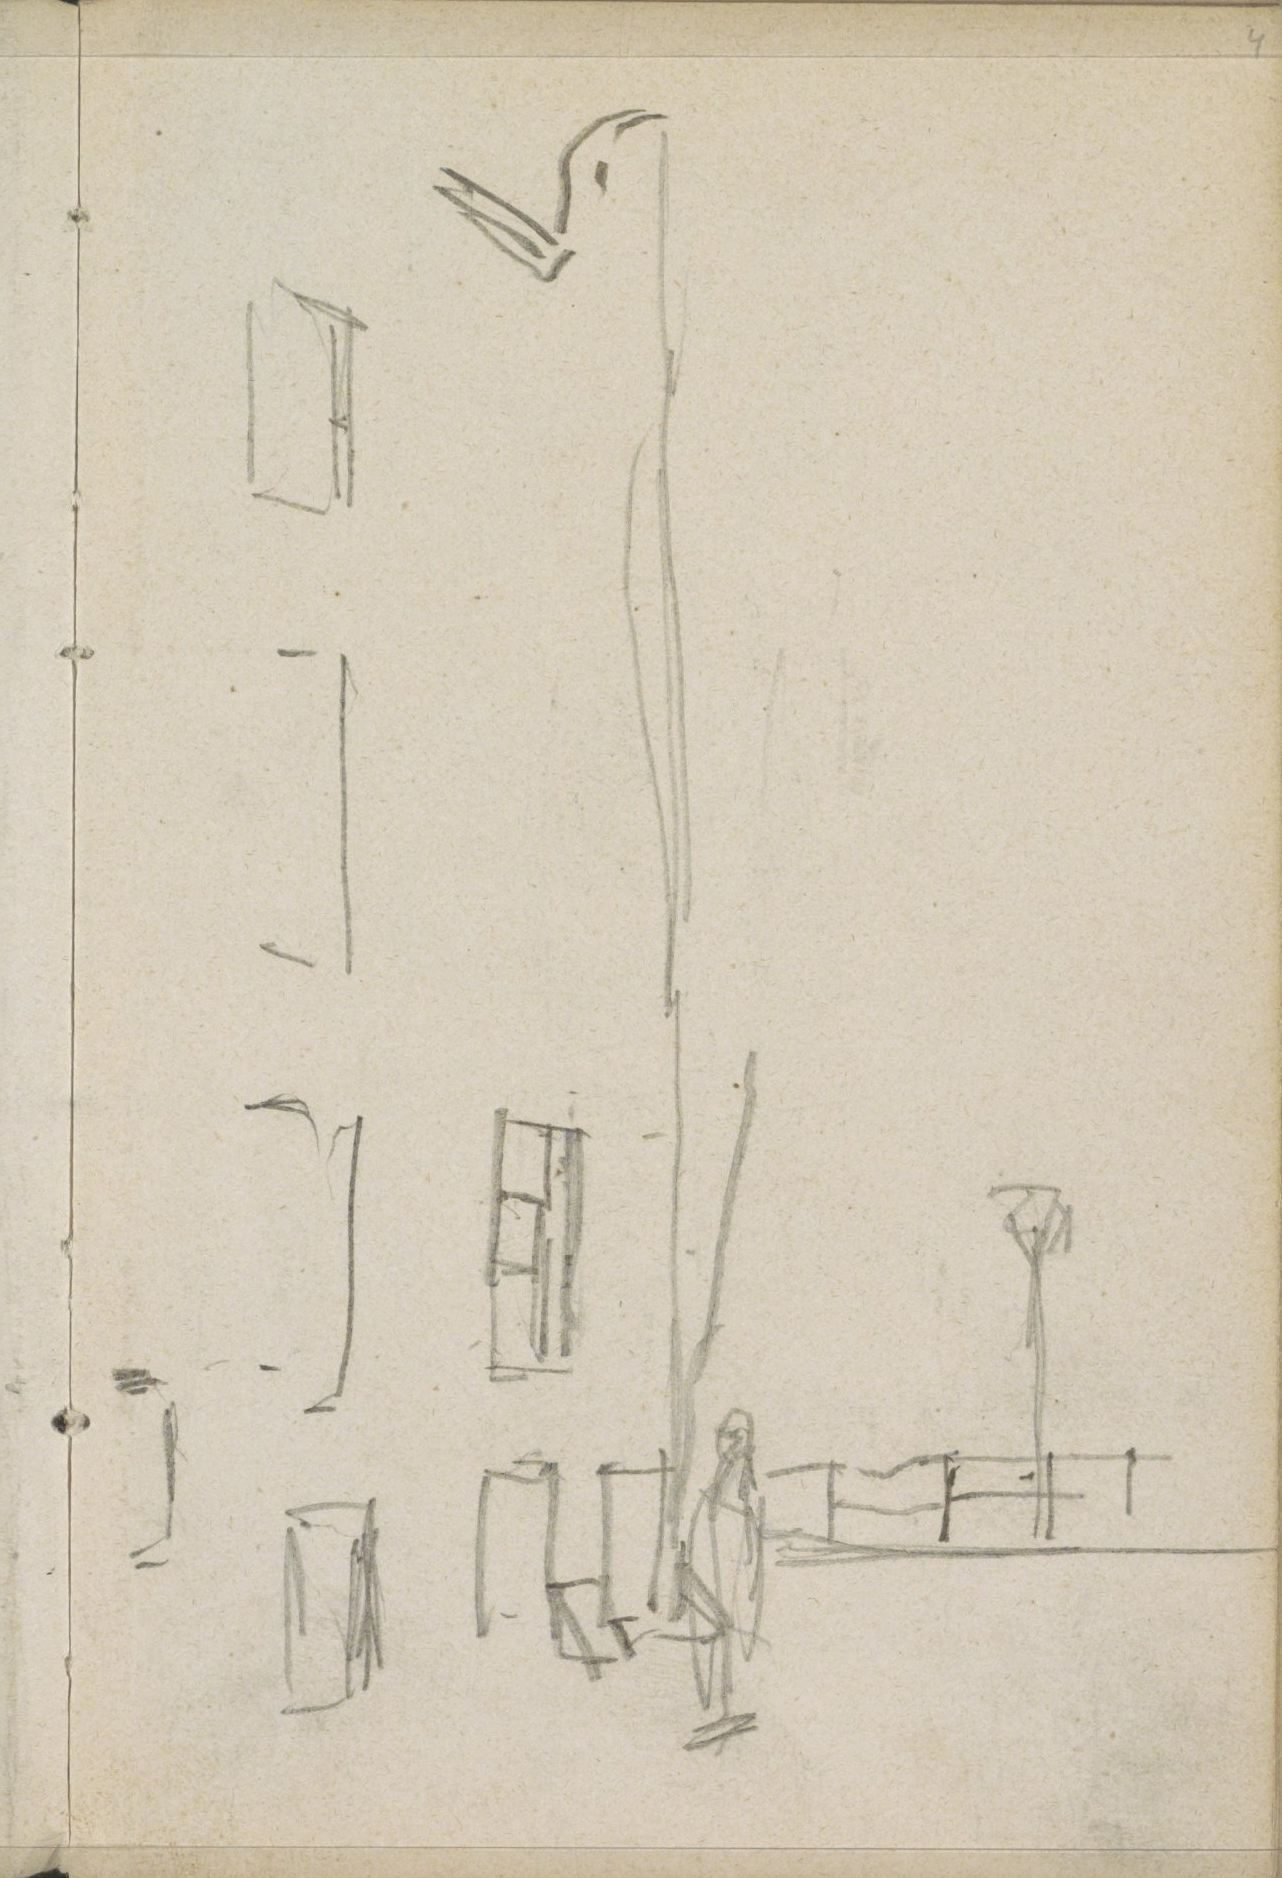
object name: sketchbook leaf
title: Figuur in een straat, mogelijk te Oudewater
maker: george hendrik breitner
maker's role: draughtsman, painter, print maker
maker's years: 1857-1923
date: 1902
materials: paper, pencil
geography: oudewater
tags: urban housing, street (+ city(-scape) with figures, staffage)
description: Pagina 4 uit een schetsboek met 46 bladen vervaardigd in de omgeving van Amsterdam, Rotterdam en Haarlem.